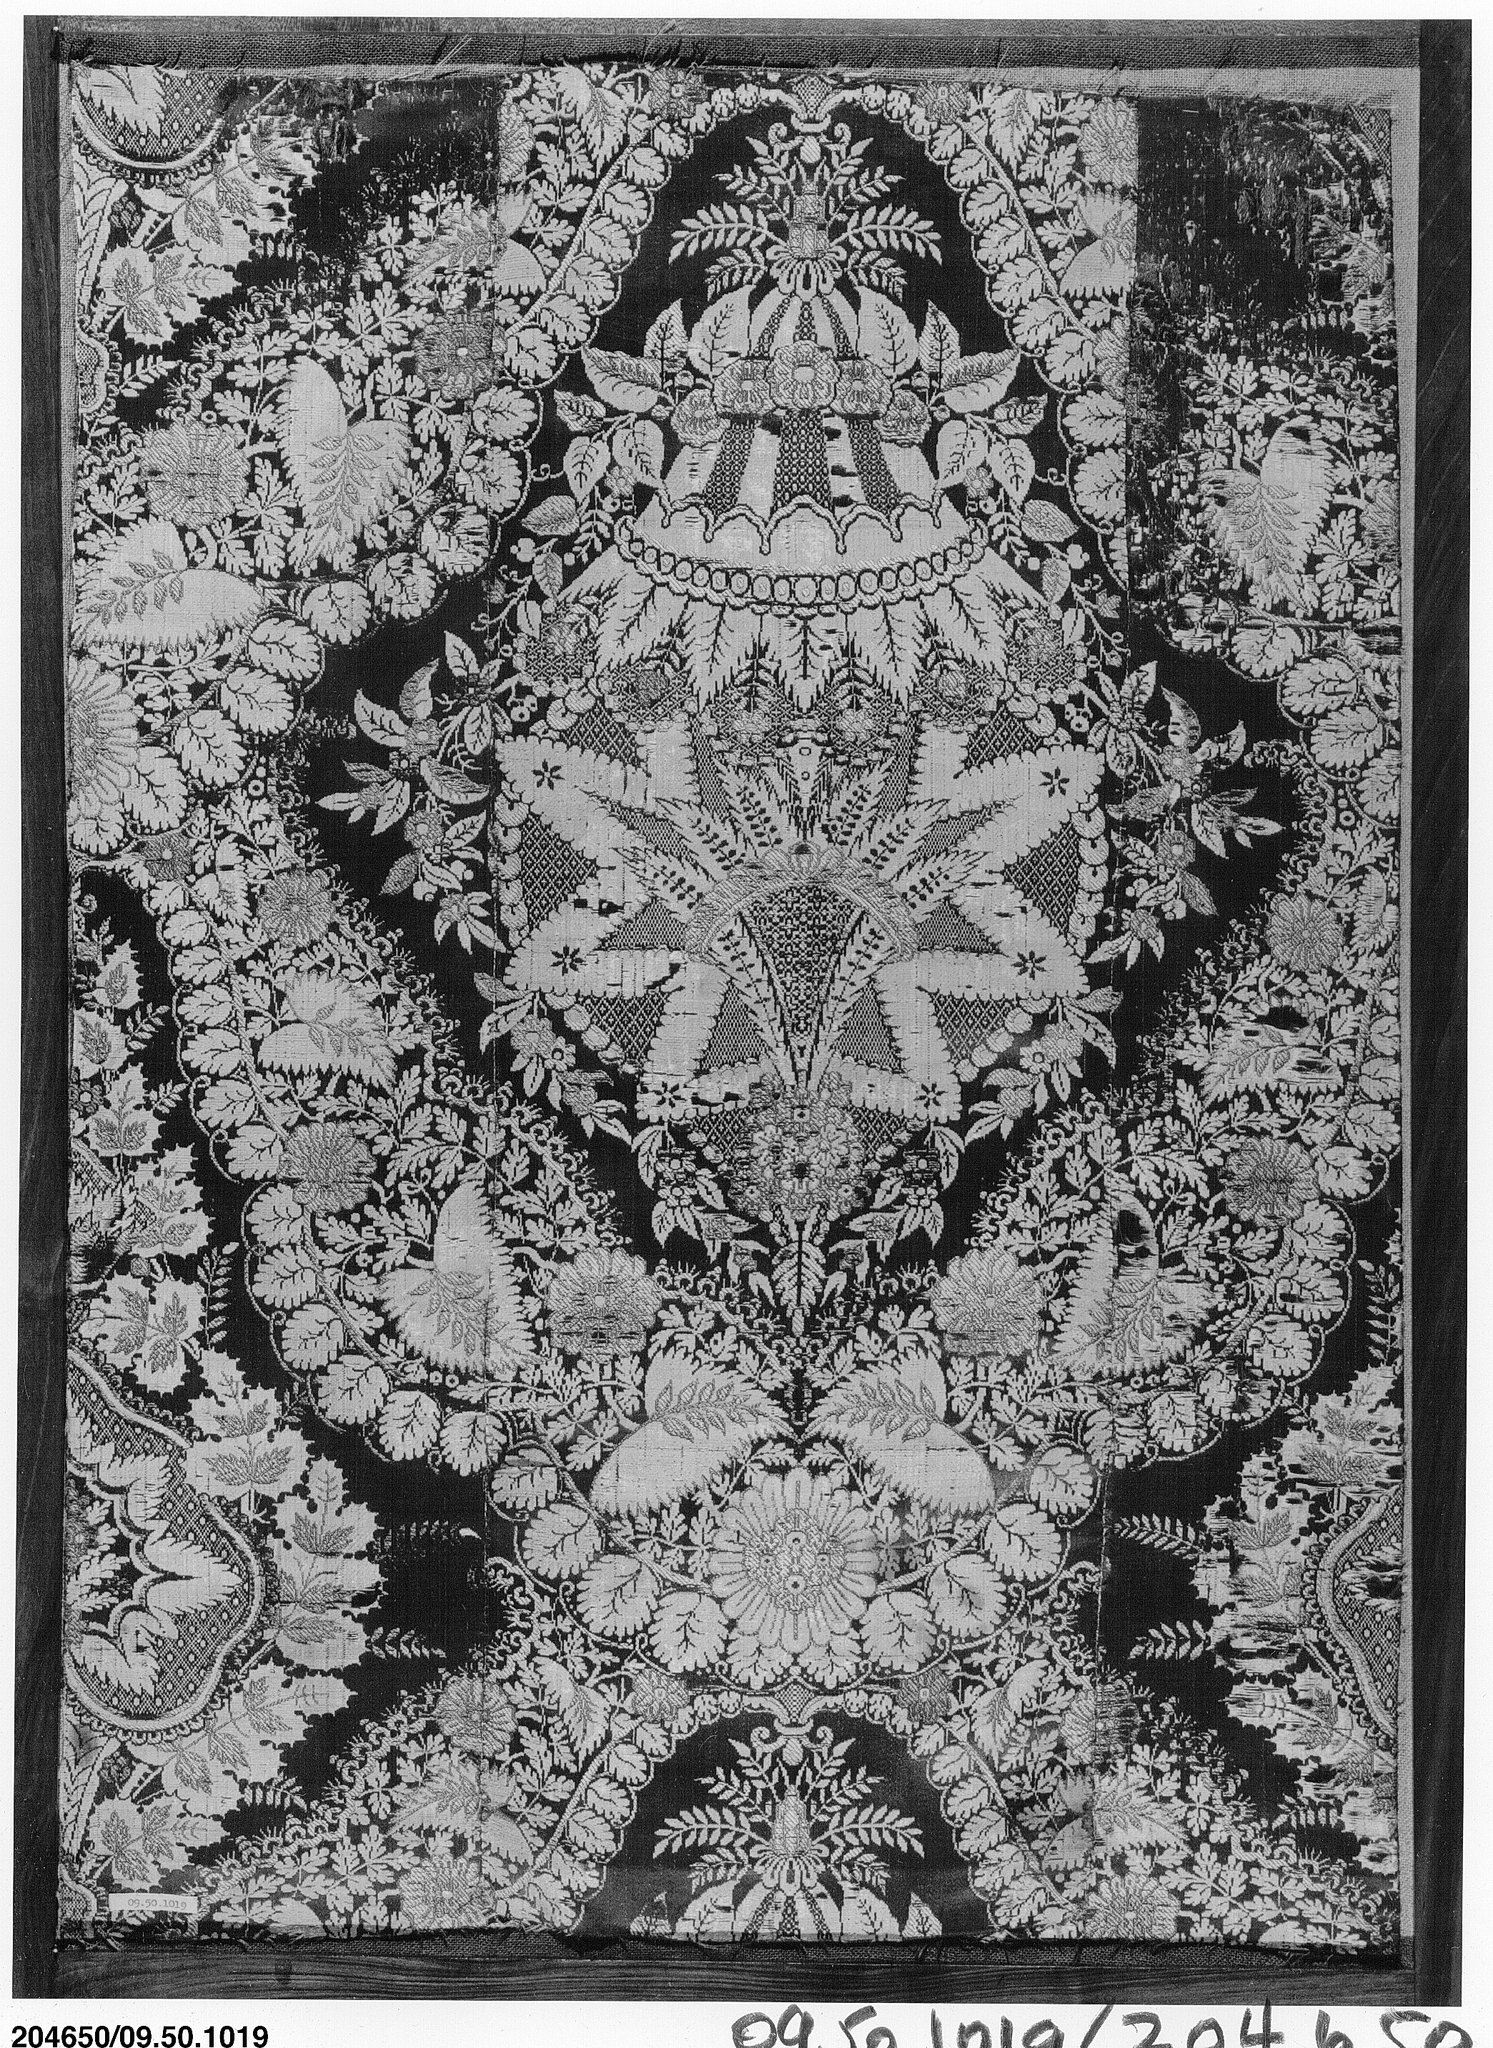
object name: piece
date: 1601-1700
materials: silk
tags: flowers,leaves